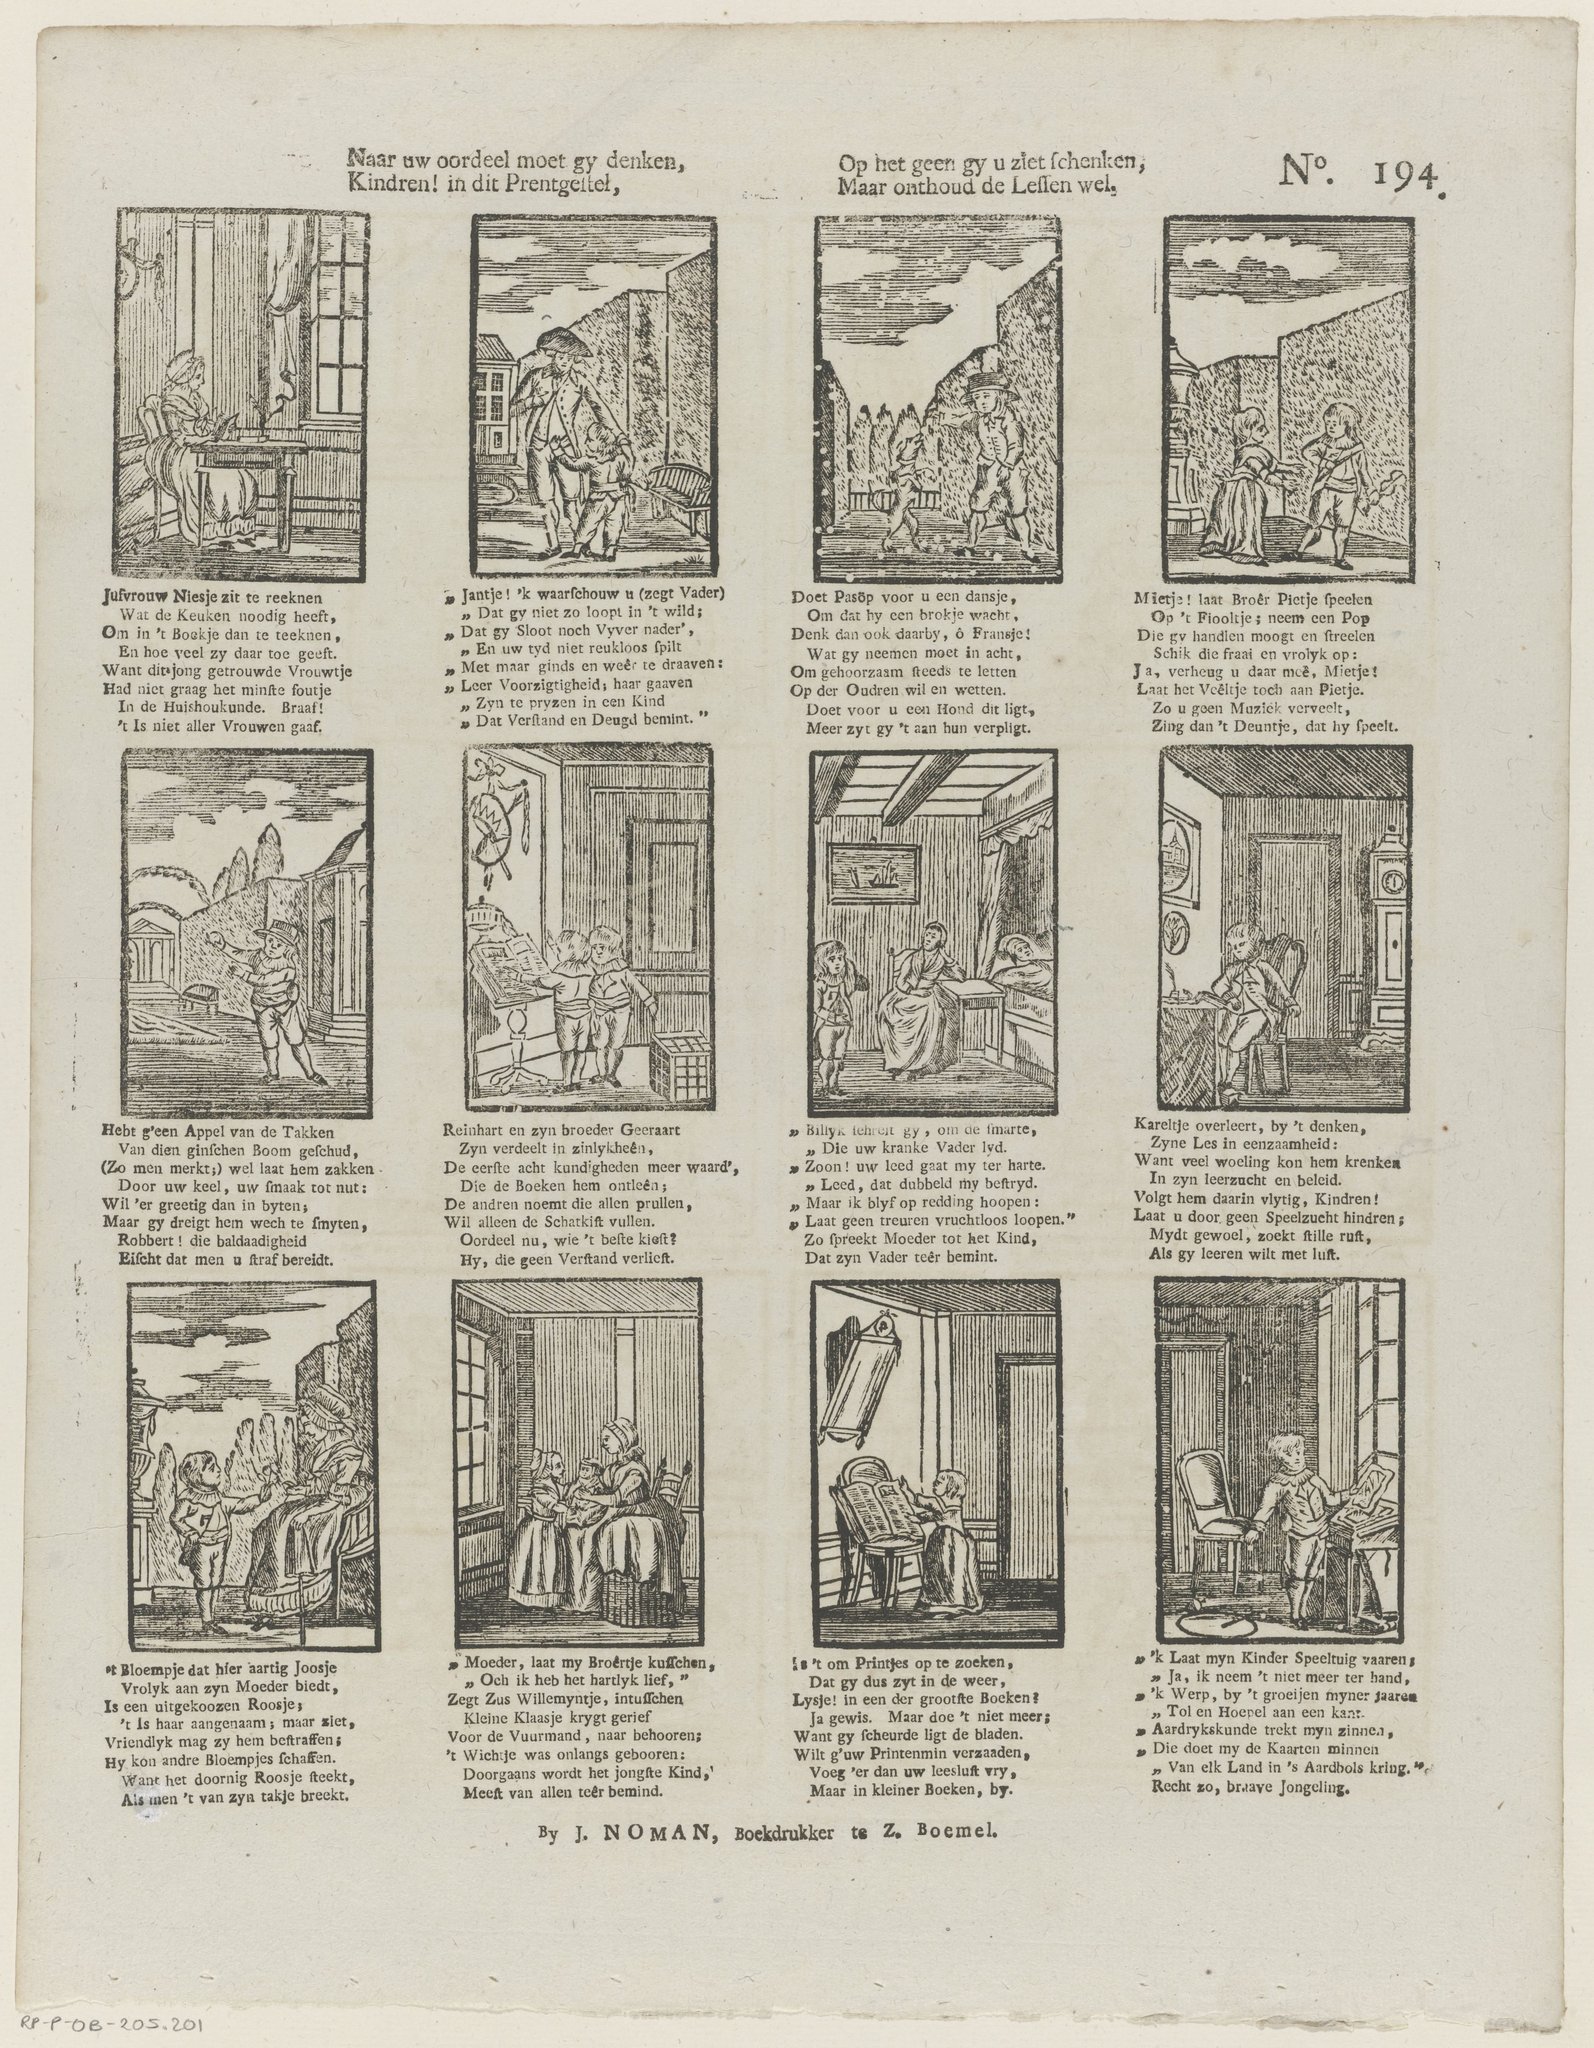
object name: print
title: Naar uw oordeel moet gy denken, / Kindren! in dit prentgestel, / Op het geen gy u ziet schenken, / Maar onthoud de lessen wel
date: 1806-1830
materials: paper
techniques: letterpress printing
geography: zaltbommel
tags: reading, child, bad behaviour, good behaviour, human life divided into stages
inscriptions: collector's mark: Lugt 2760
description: Blad met 12 voorstellingen over het kinderleven. Onder elke afbeelding een achtregelig vers. Genummerd rechtsboven: No. 194.